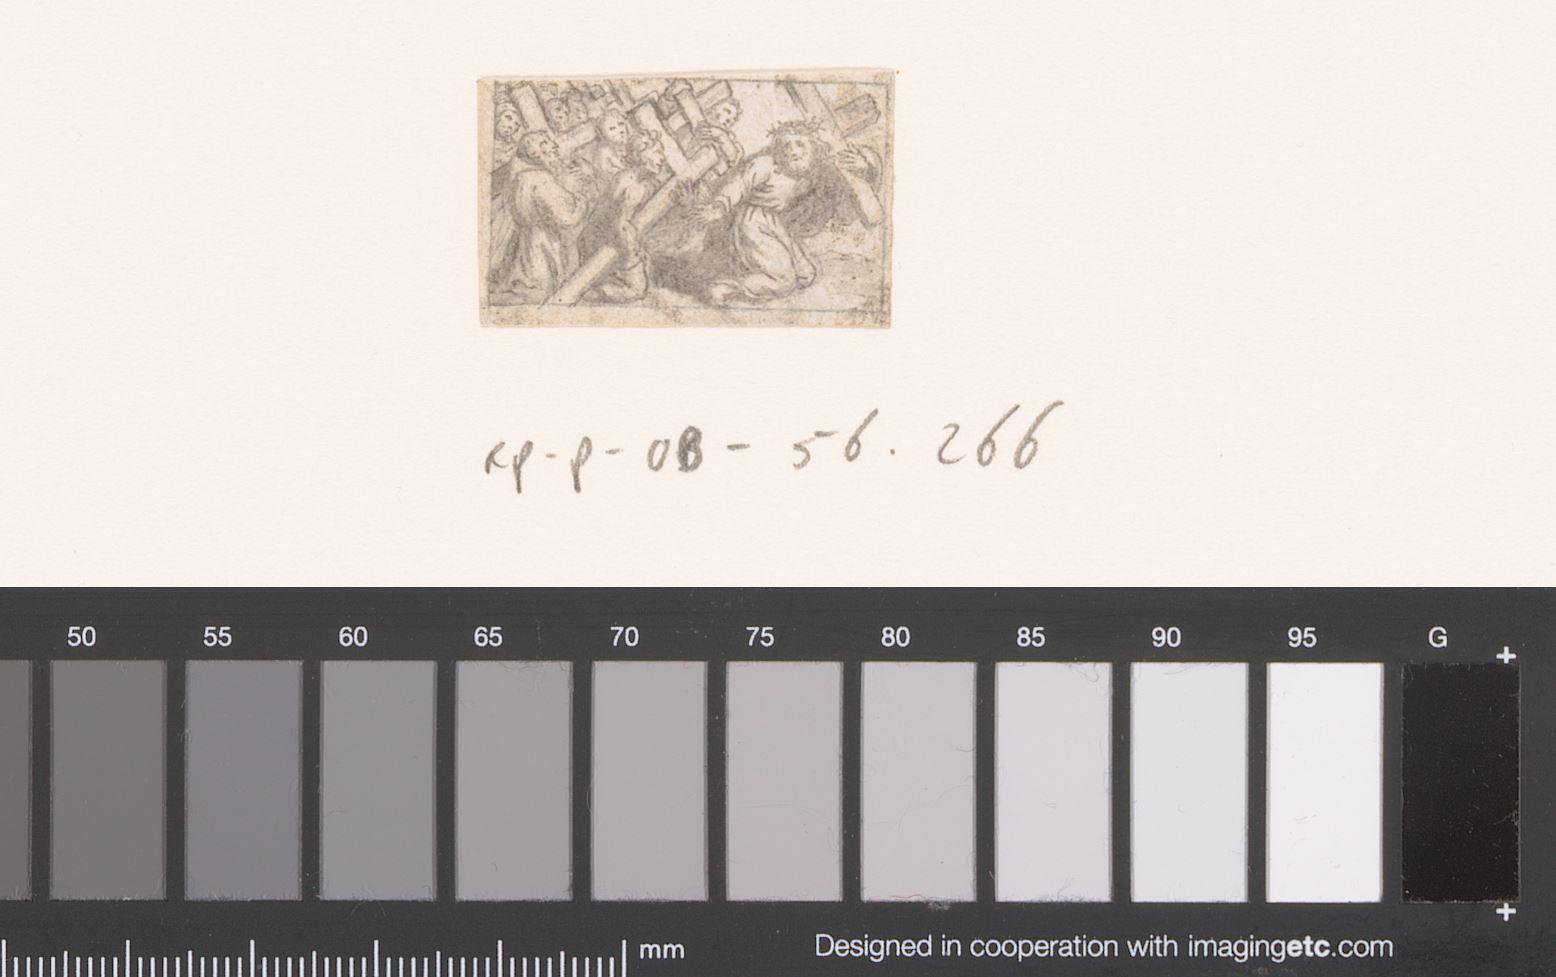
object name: print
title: Kruisdraging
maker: Anonymous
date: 1600-1699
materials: paper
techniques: etching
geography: germany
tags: carrying of the cross: christ bearing the cross, alone or with the help of others (e.g. simon the cyrenian)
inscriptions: collector's mark: Lugt 2228